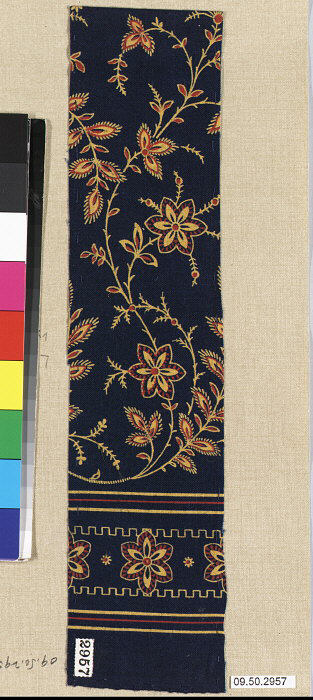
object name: piece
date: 1801-1900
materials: cotton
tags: flowers,leaves